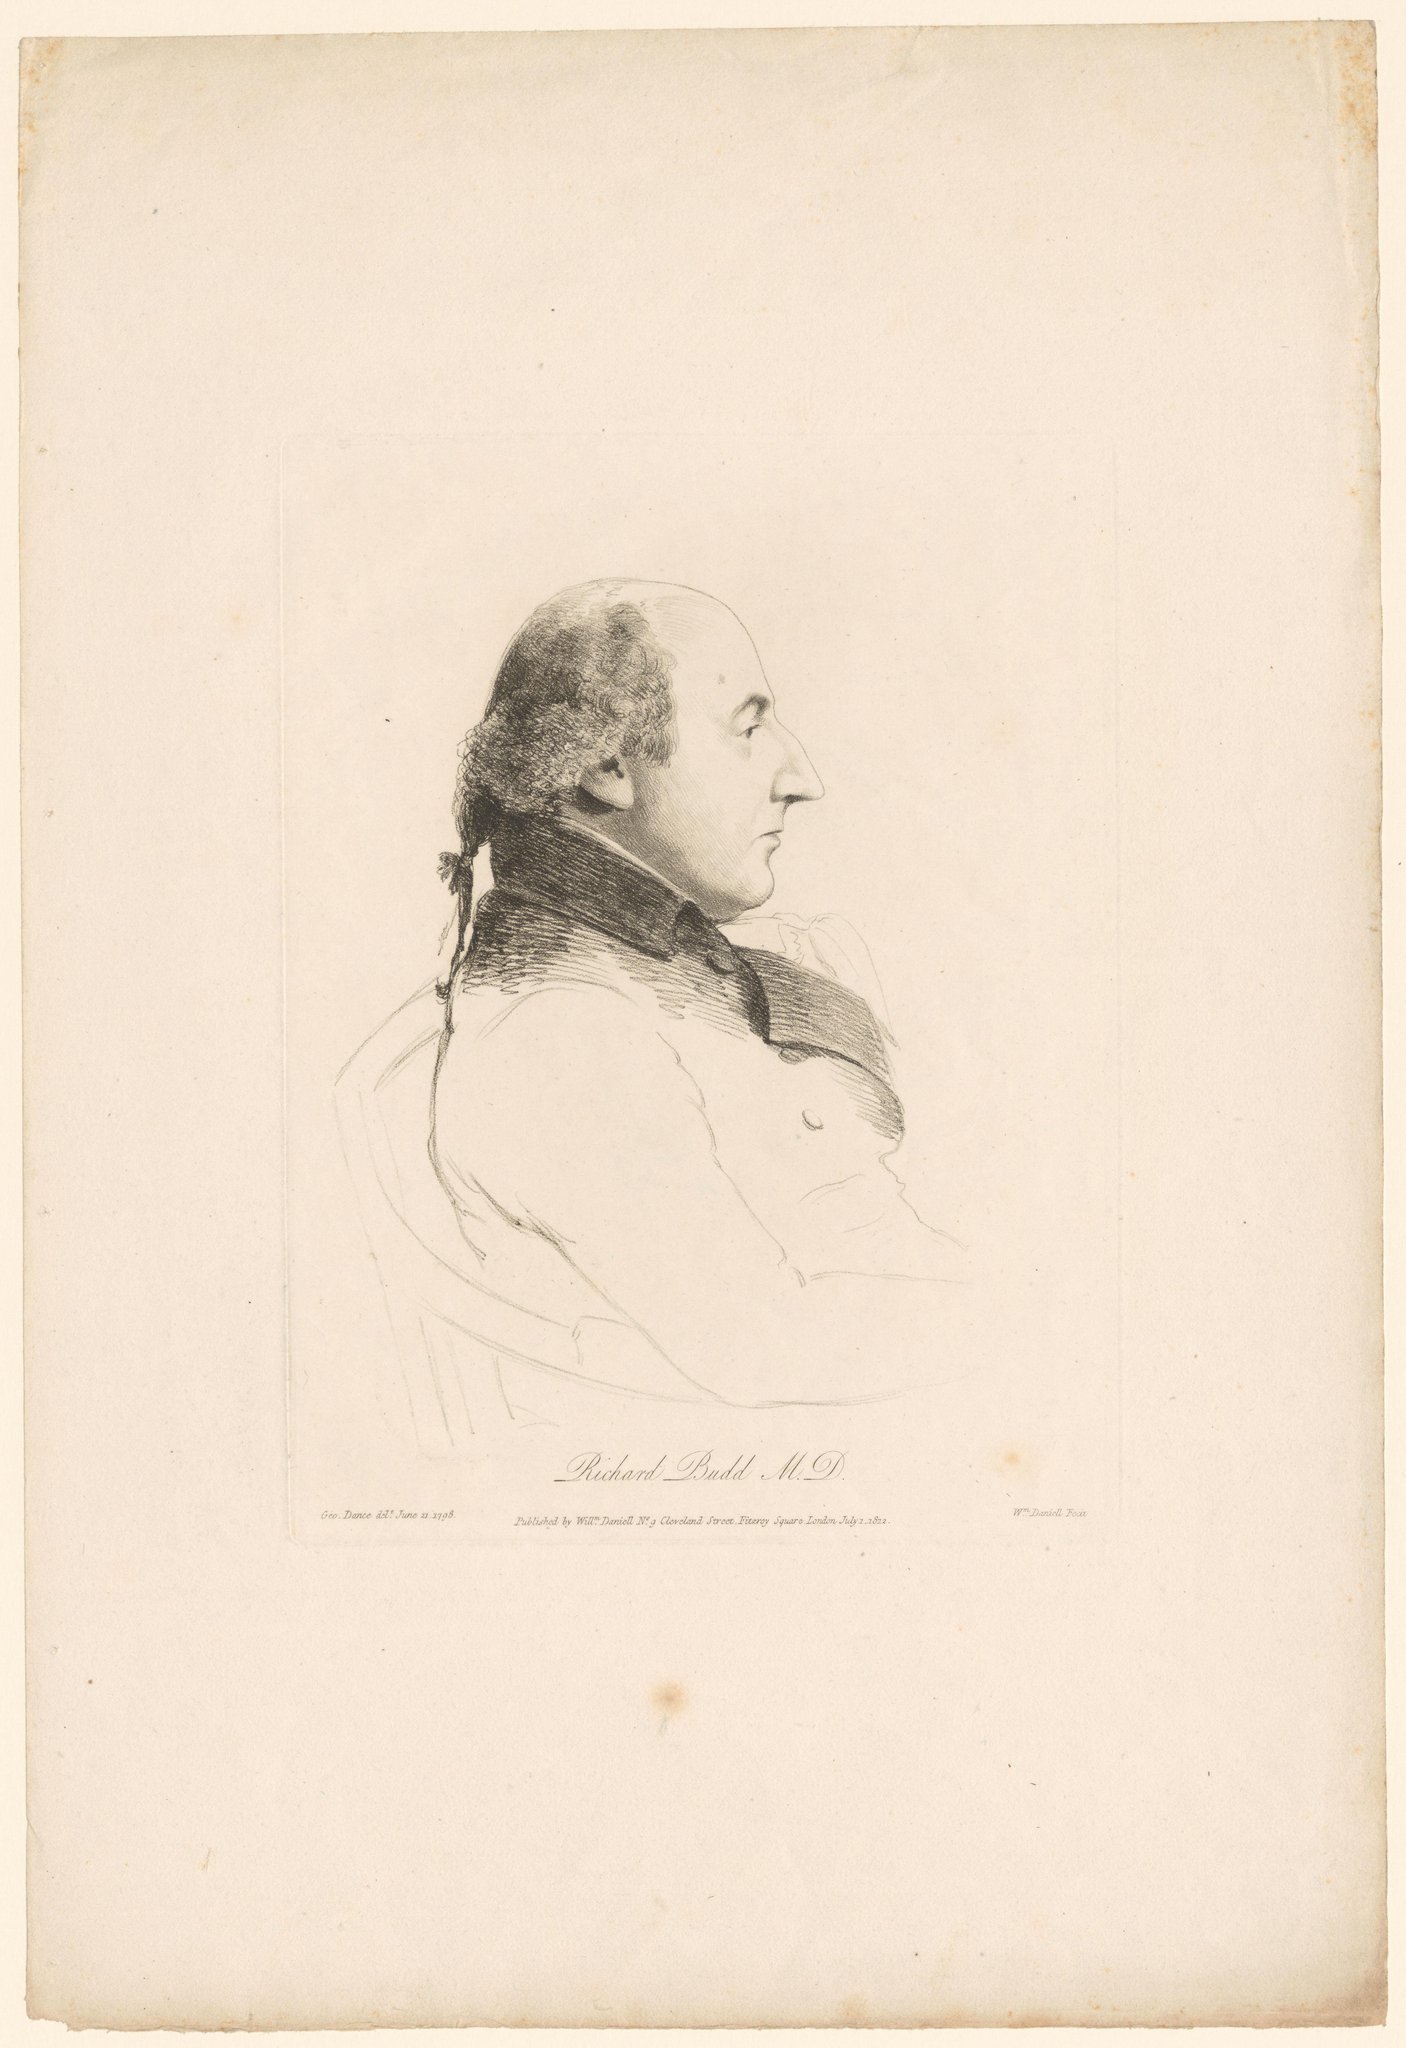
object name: print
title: Portret van Richard Budd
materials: paper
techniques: printmaking, etching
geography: london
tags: historical persons, physician, doctor (+ portrait of scholar, scientist)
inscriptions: collector's mark: Lugt 2228